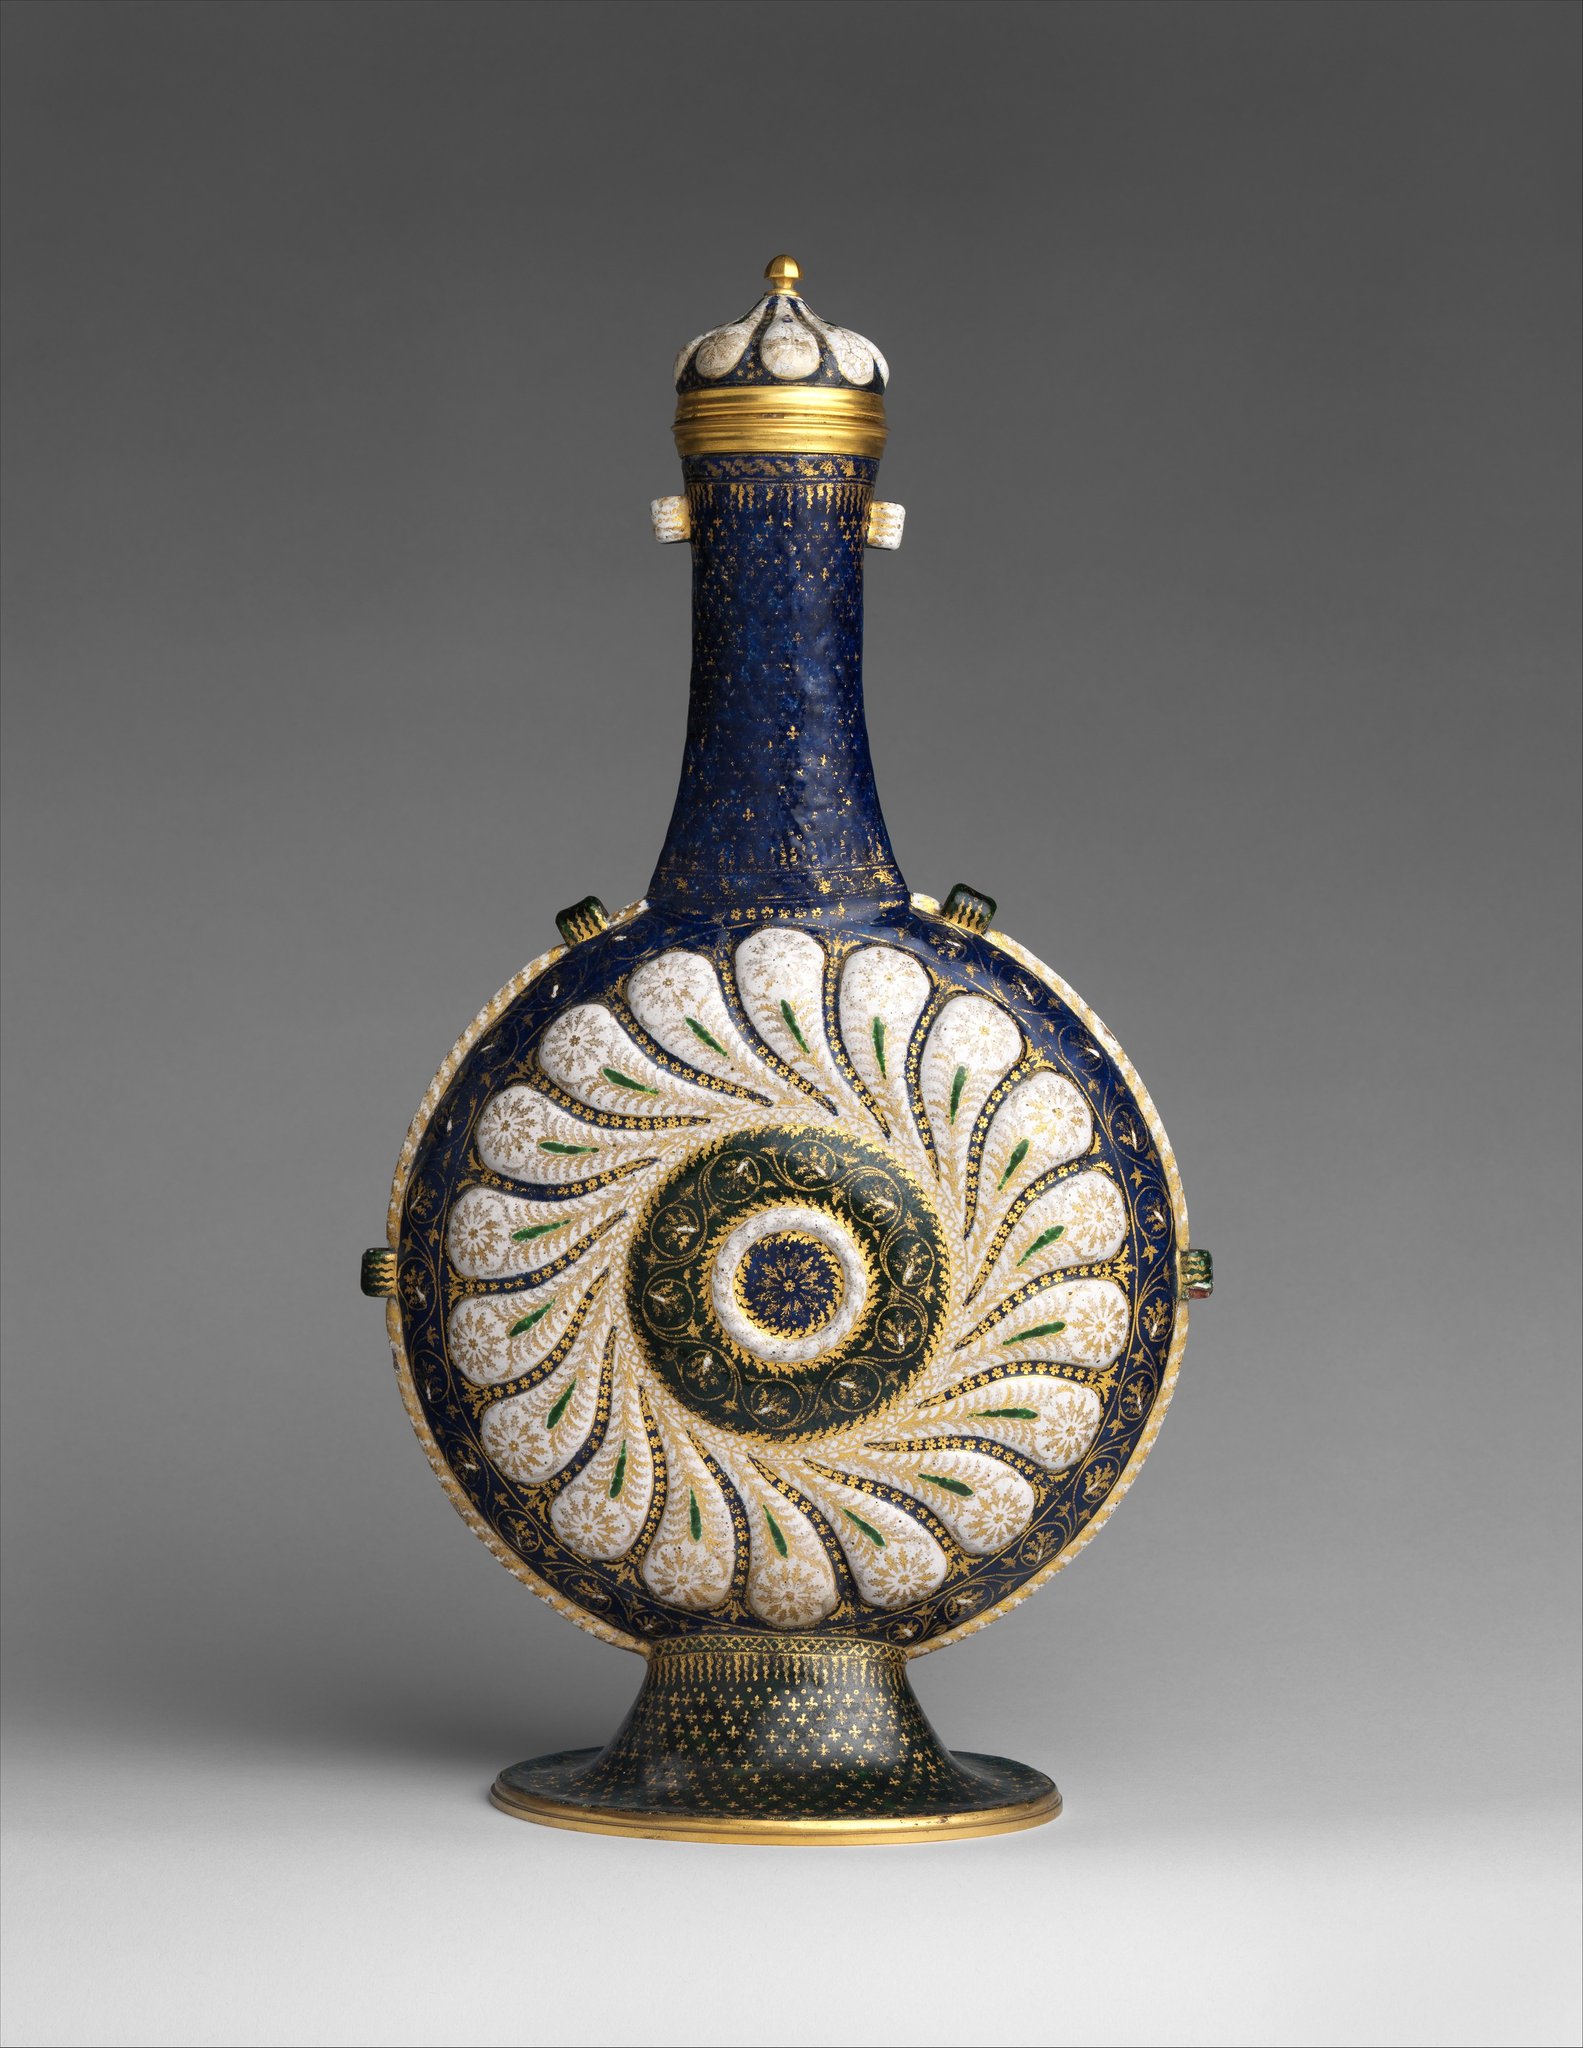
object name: pilgrim bottle with cover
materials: brass, copper, enamel, gilt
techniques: painting